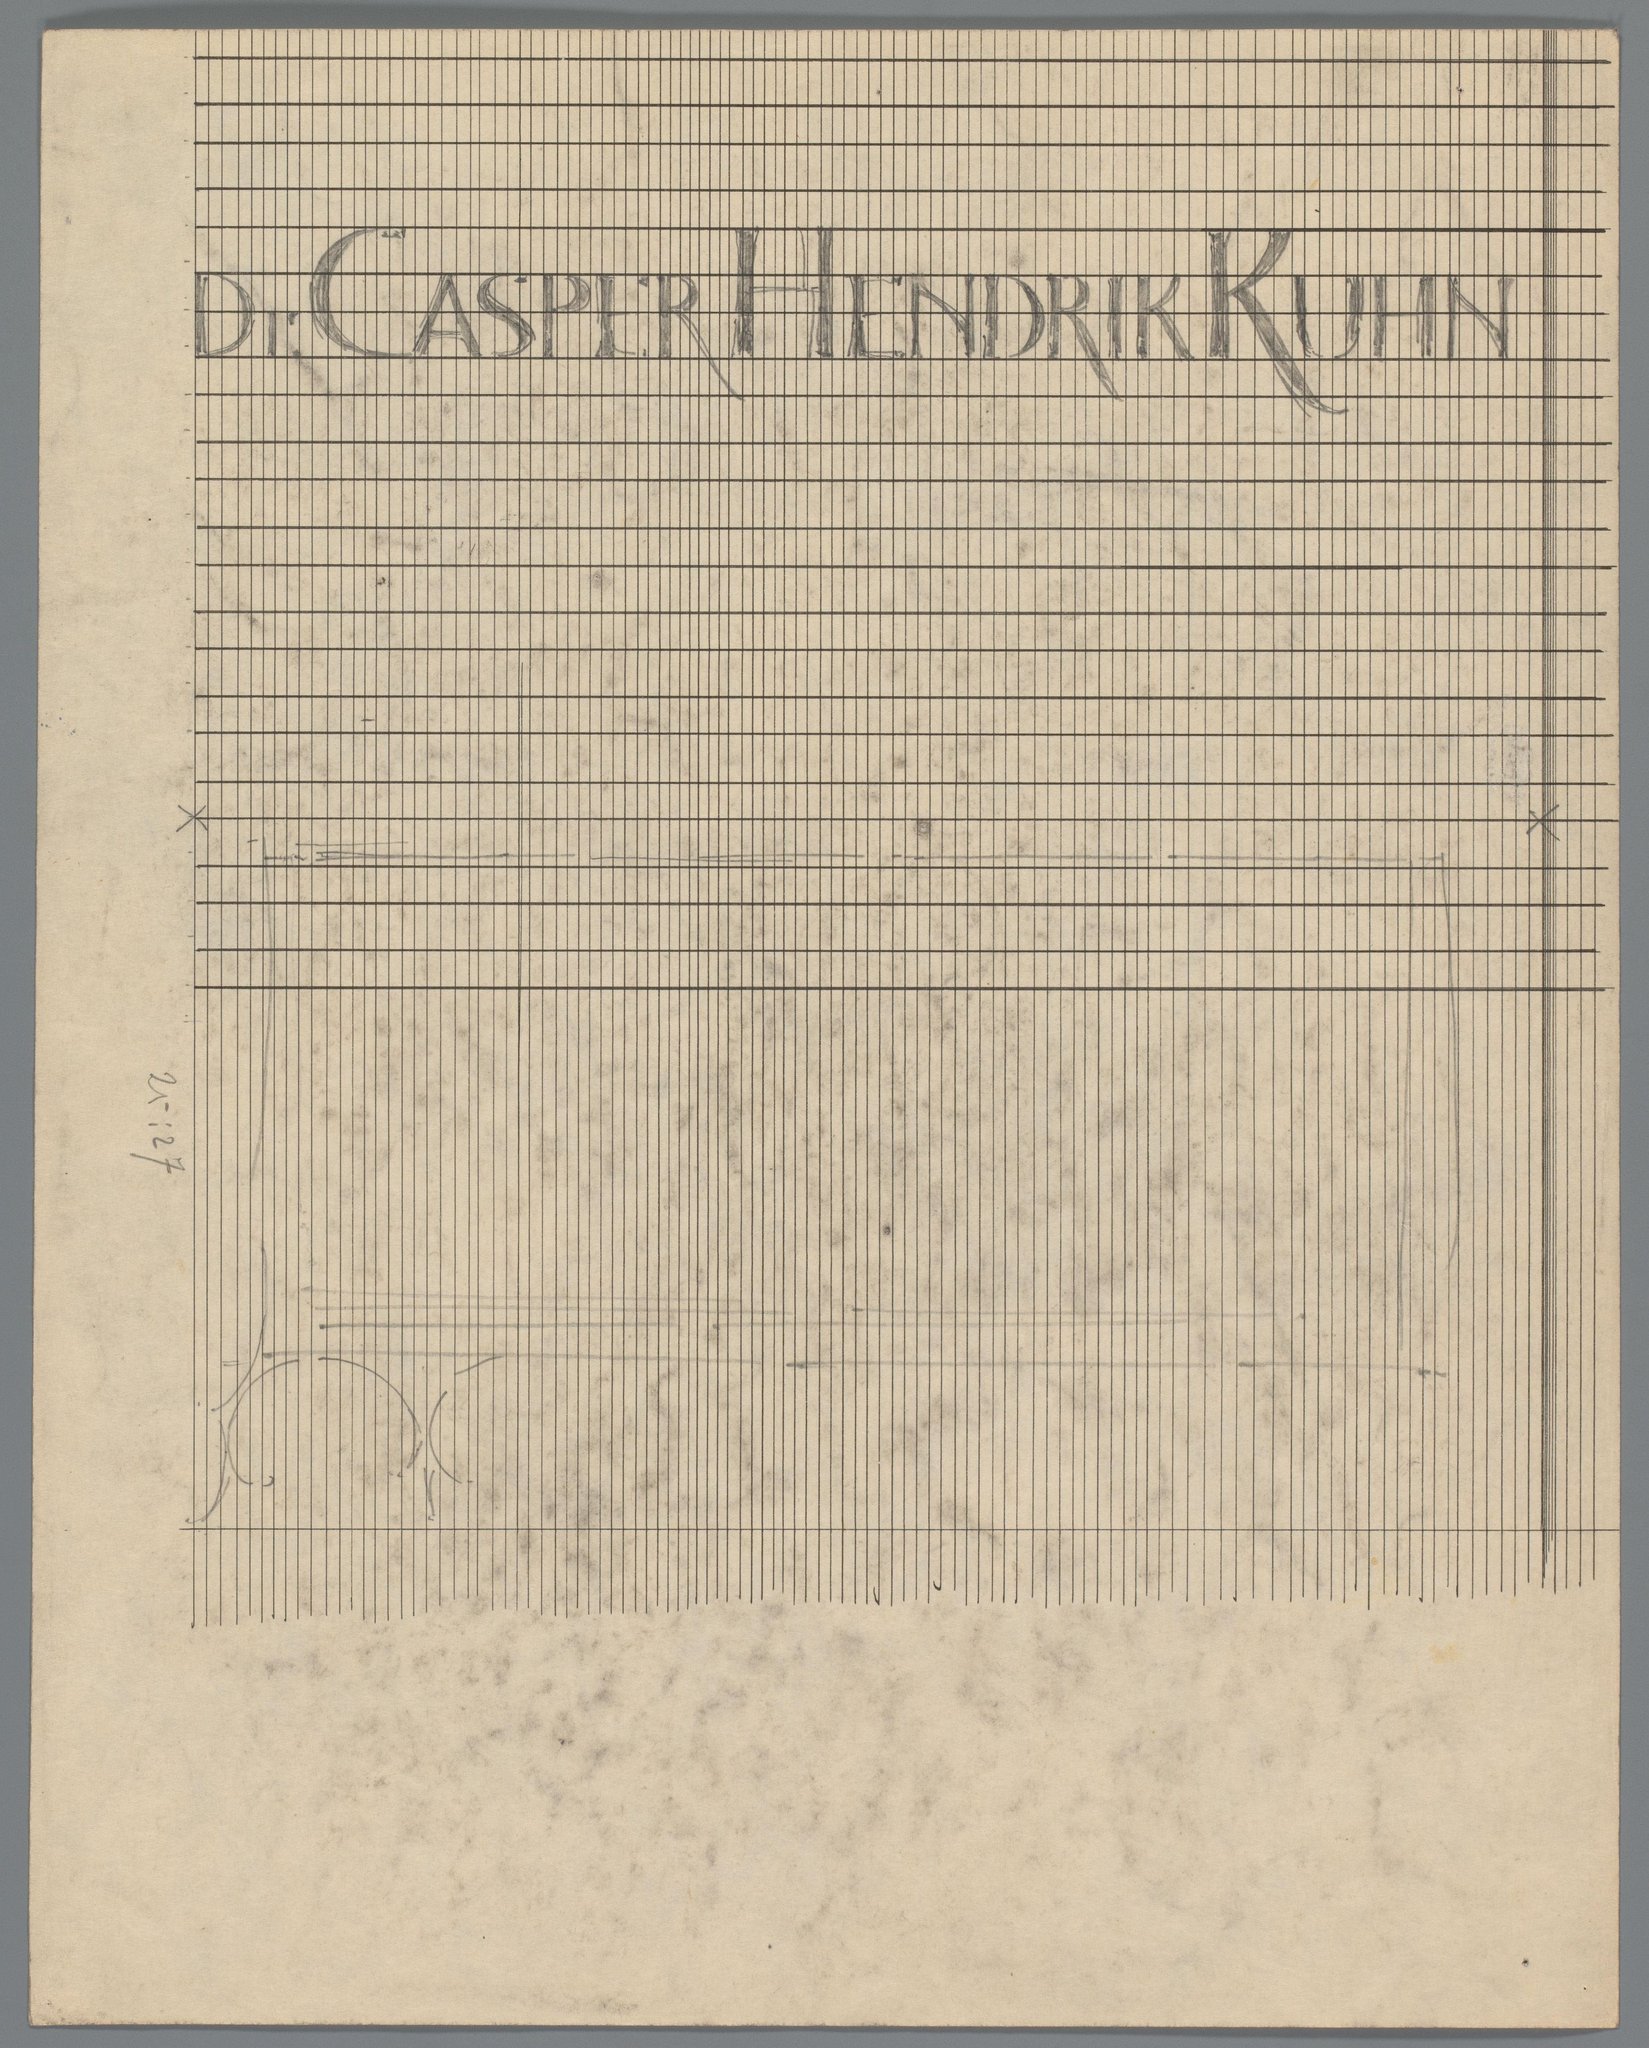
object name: drawing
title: Studie voor een getuigschrift voor Casper Hendrik Kuhn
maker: gerrit willem dijsselhof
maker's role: designer, draughtsman, print maker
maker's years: 1866-1924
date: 1876-1924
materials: pencil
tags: crustaceans: lobster